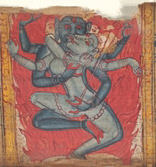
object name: folio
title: Chakrasamvara in Sexual Union with His Consort, Vajravarahi, Leaf from a dispersed Ashtasahasrika Prajnaparamita (Perfection of Wisdom) Manuscript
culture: indian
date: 1101-1200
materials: ink, leaf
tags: couples,men,women